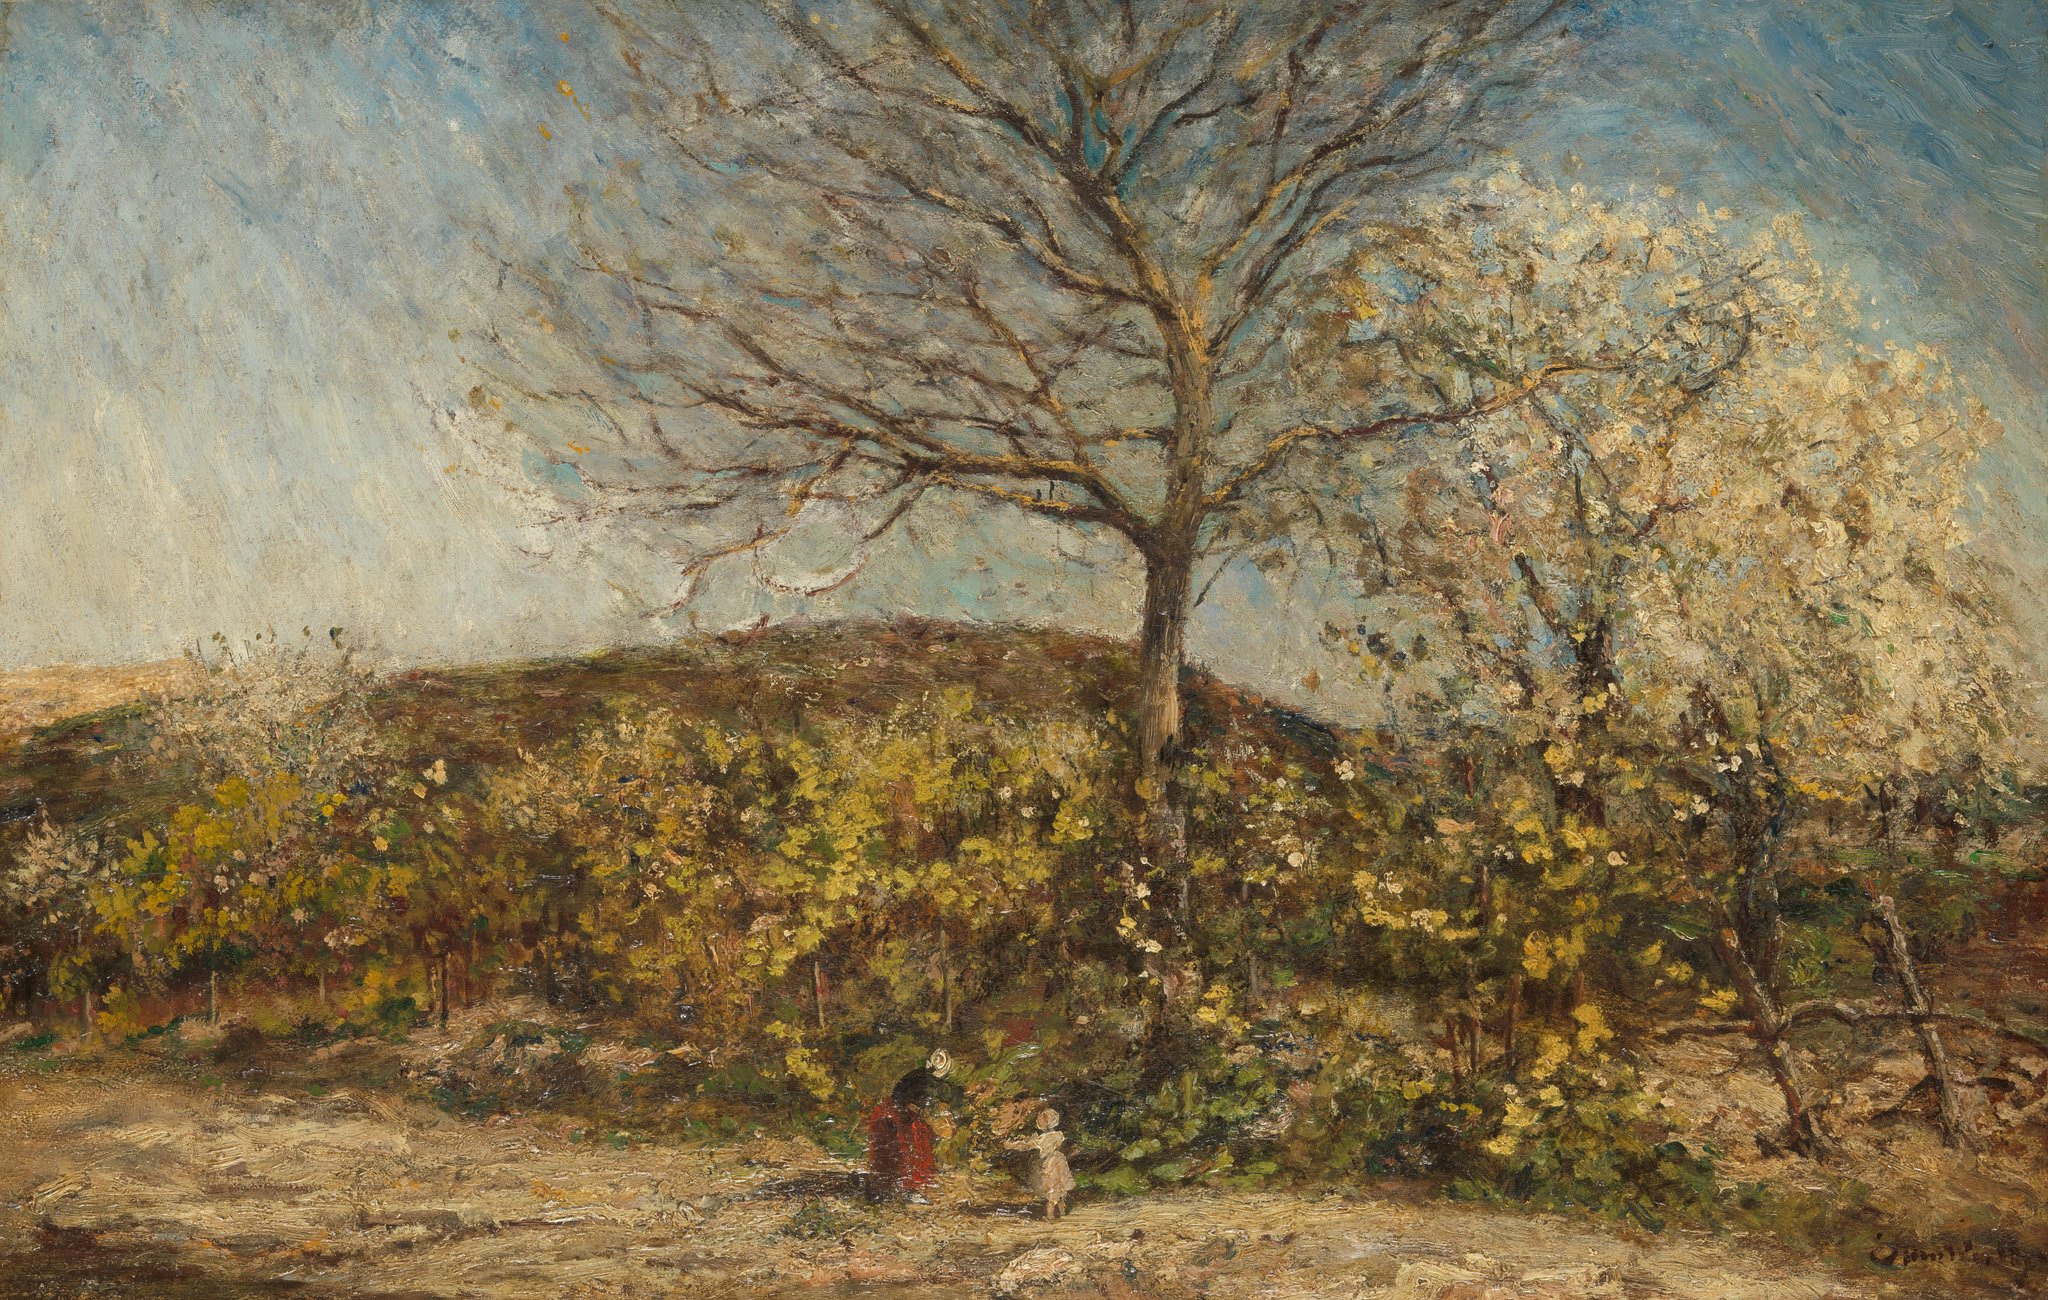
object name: painting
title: Landschap met bloeiende boomgaard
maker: adolphe joseph thomas monticelli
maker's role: painter, print maker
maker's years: 1824-1886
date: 1870-1886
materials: oil, panel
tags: orchard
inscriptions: signature: ‘A. Monticelli’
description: Landschap met bloeiende boomgaard. Een moeder met kind bij de voet van een boom.